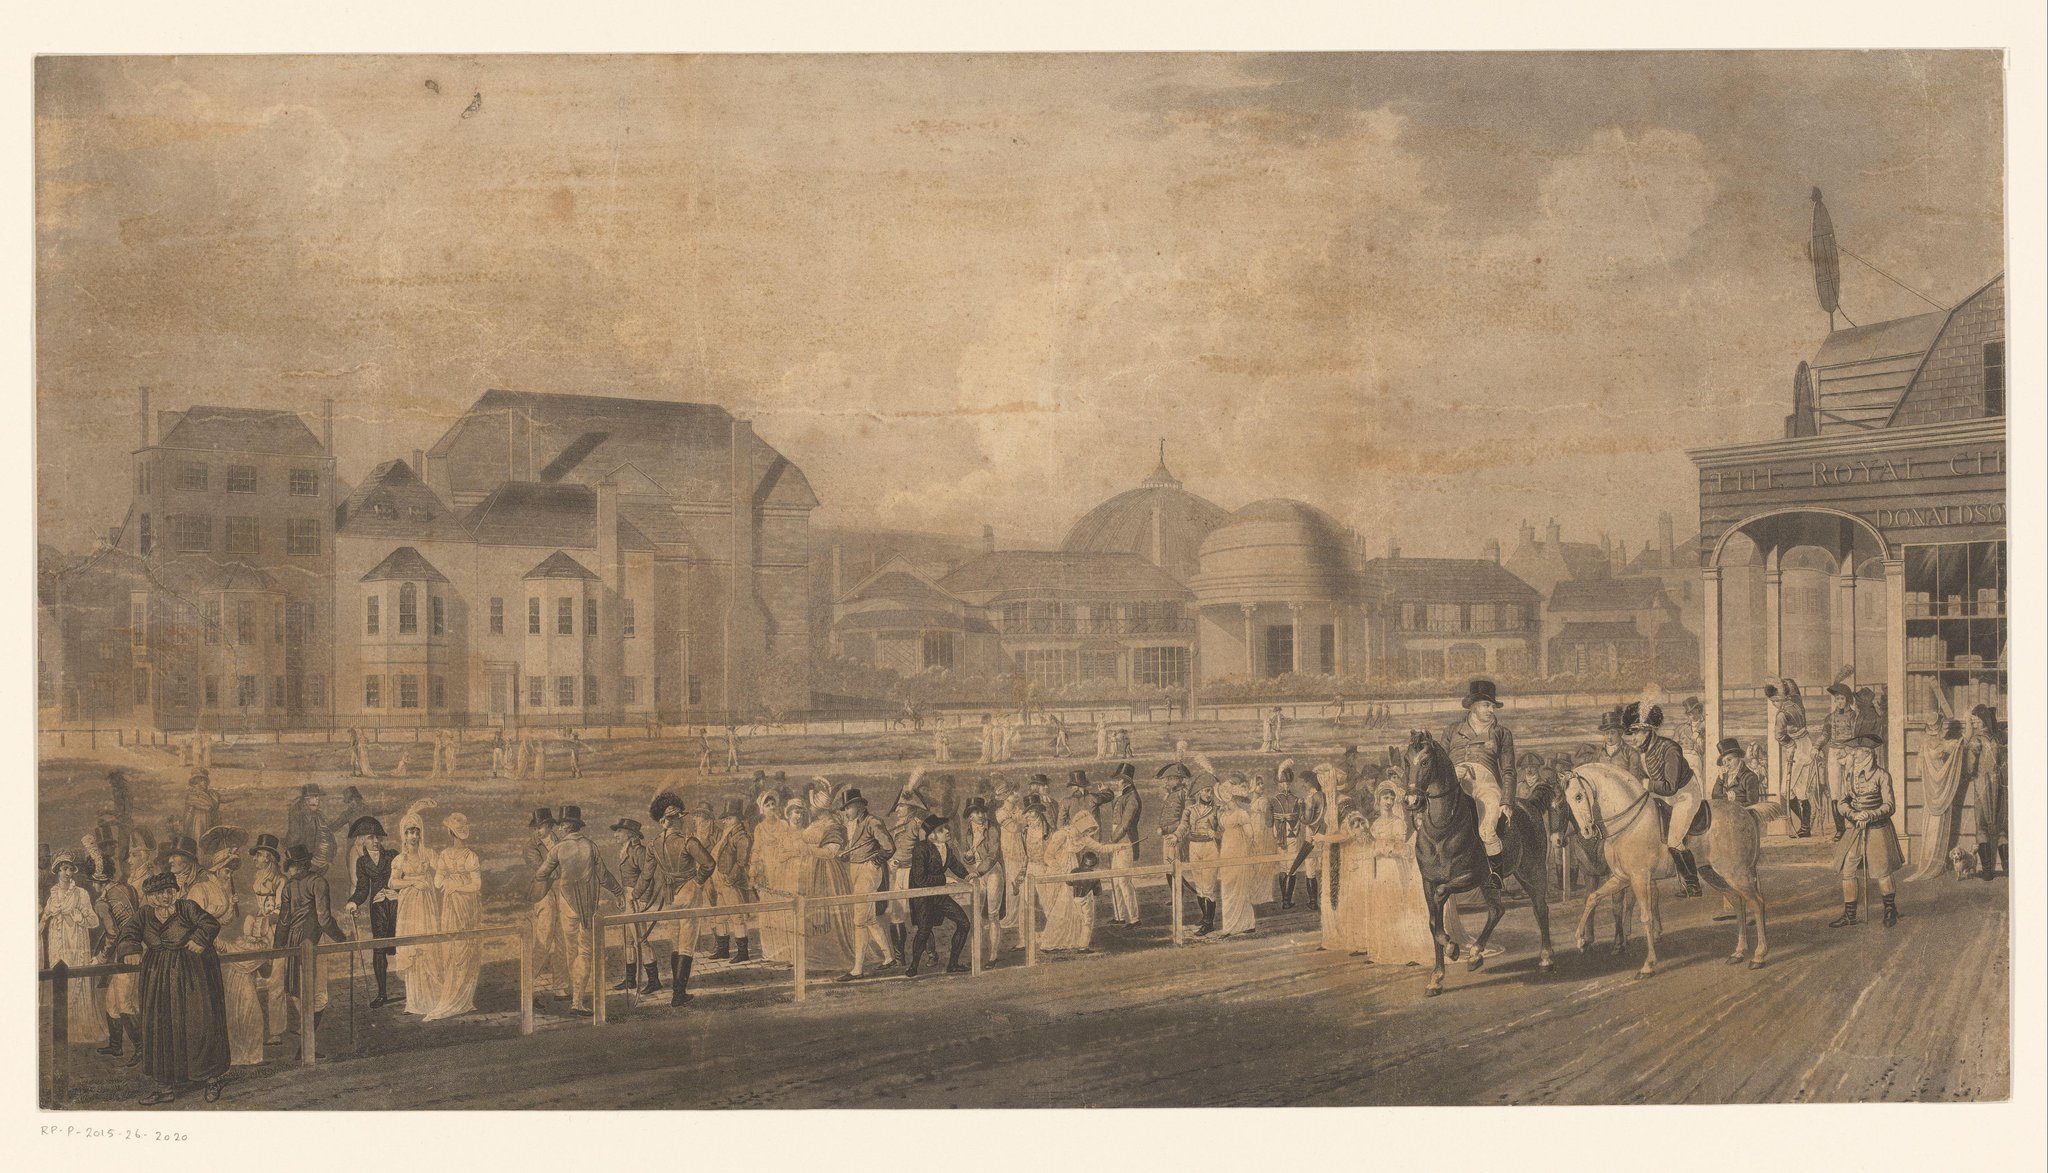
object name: print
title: Stadsgezicht met twee mannen te paard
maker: Anonymous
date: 1775-1850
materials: paper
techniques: aquatint, etching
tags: riding a horse, ass, or mule; rider, horseman, private soldier, city-view in general; 'veduta' (+ city(-scape) with figures, staffage), shop-window, show-window, book-shop, bookseller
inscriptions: collector's mark: Lugt 2228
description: Stadsgezicht met op de voorgrond twee manenn te paard. Achter een hekwerk menigte mannen en vrouwen, waaronder veel militairen, op een verhard pad. Verschillende gebouwen in de achtergrond en rechts voor een houten gebouw met de etalage van een boekhandel.